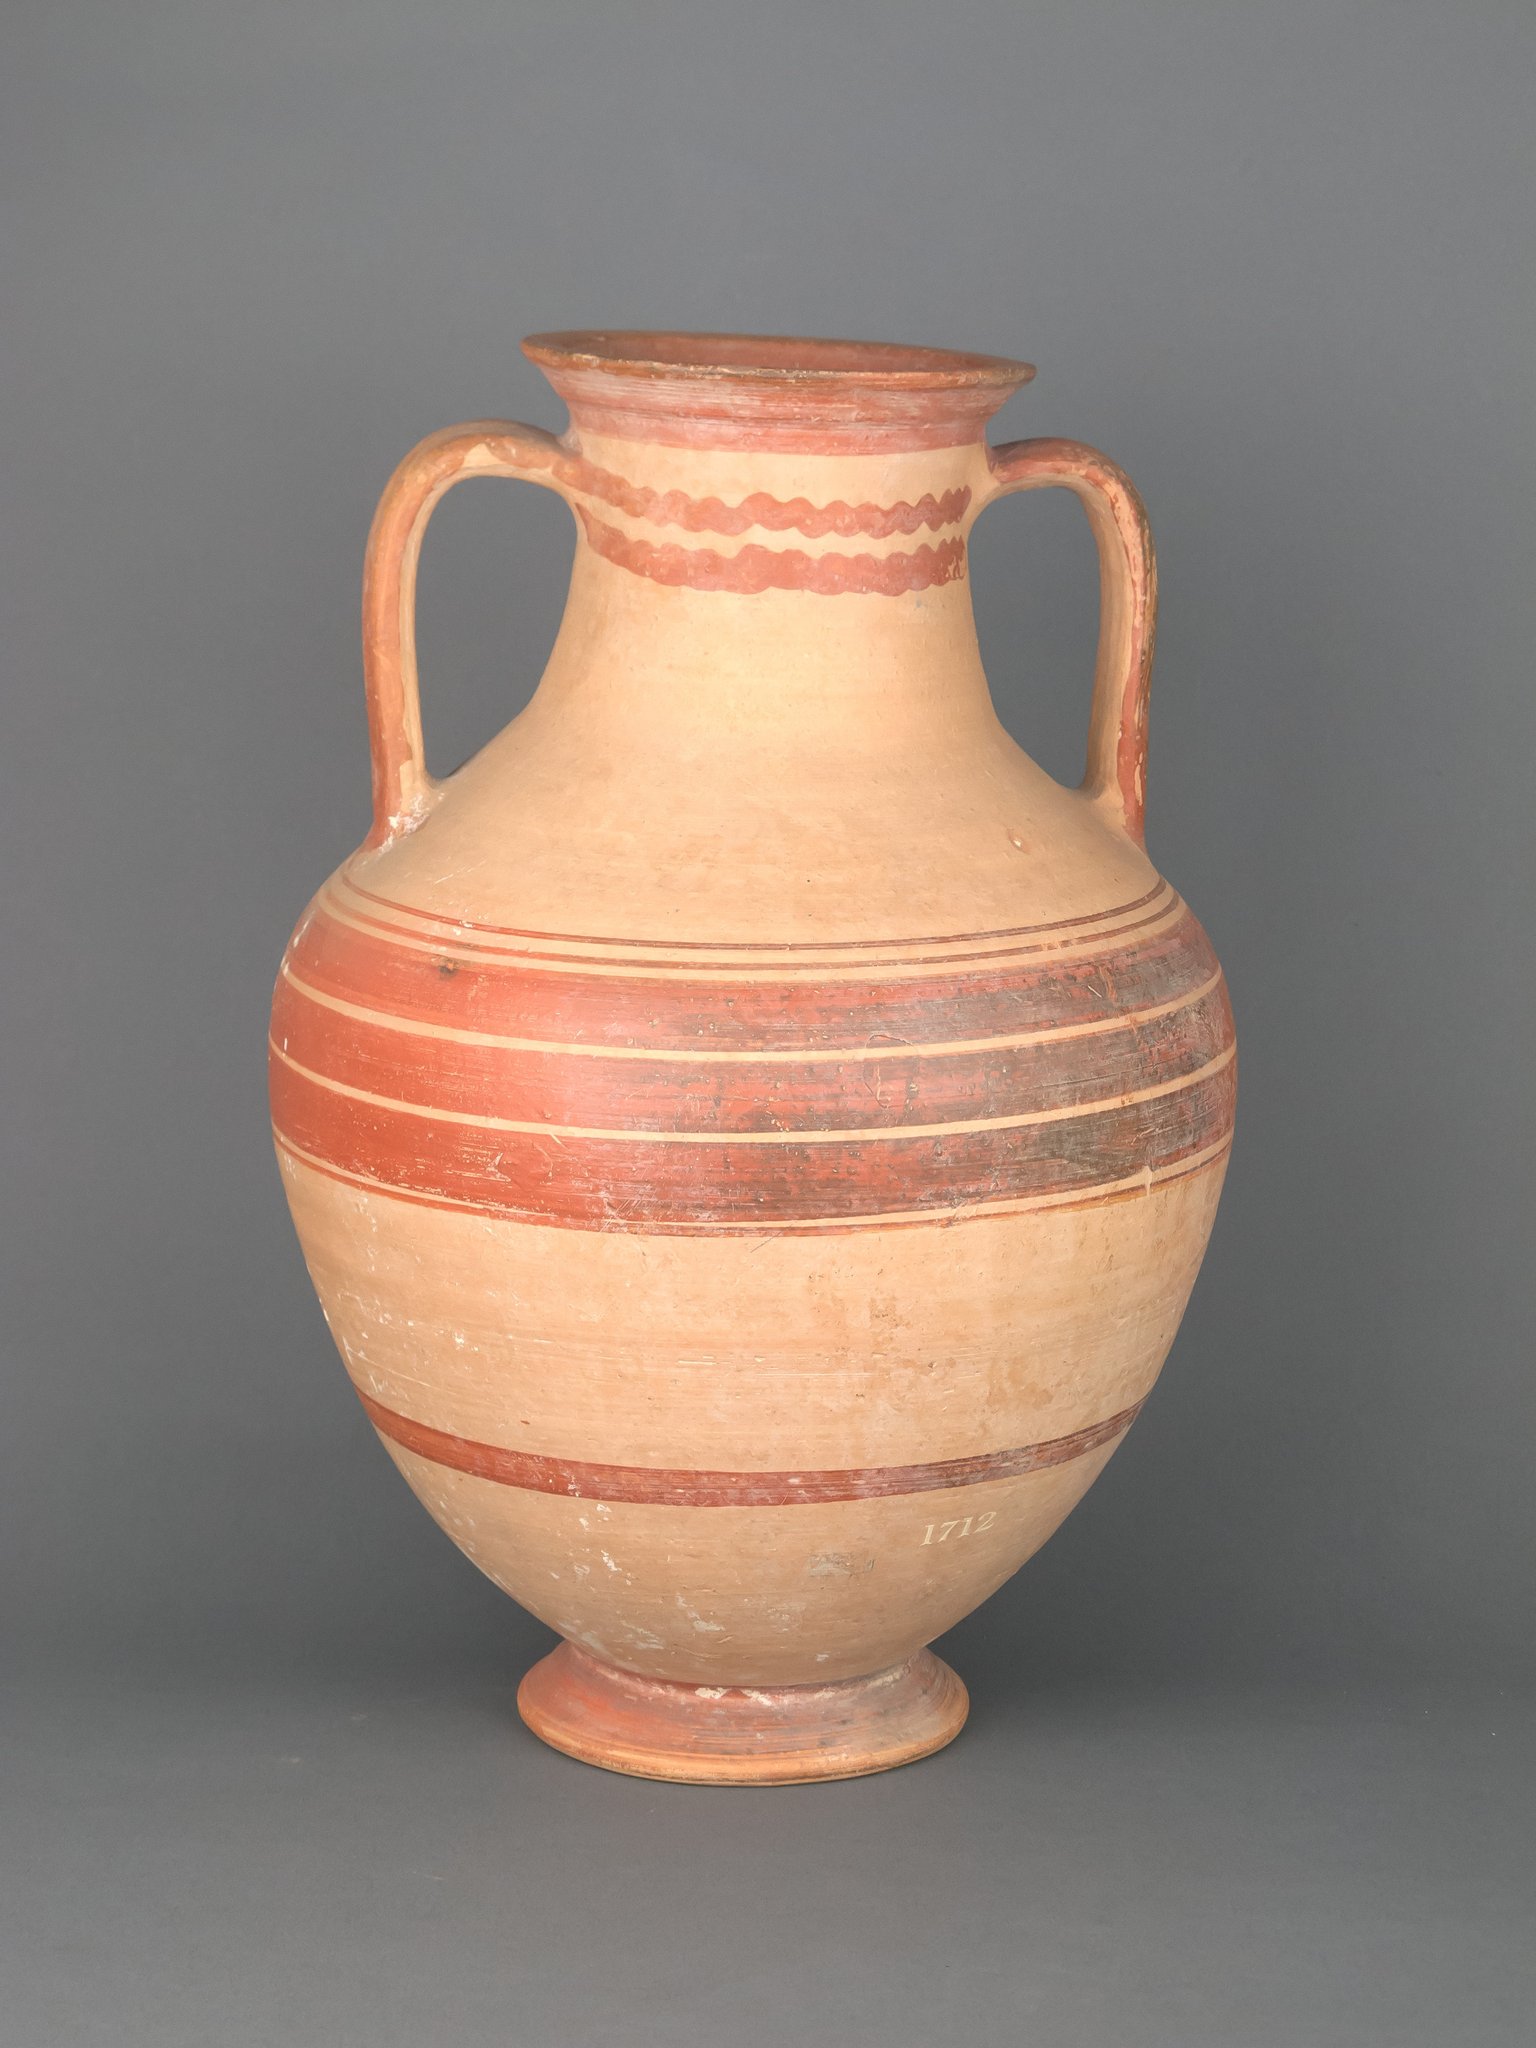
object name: amphora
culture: east greek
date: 900-700 BCE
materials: terracotta